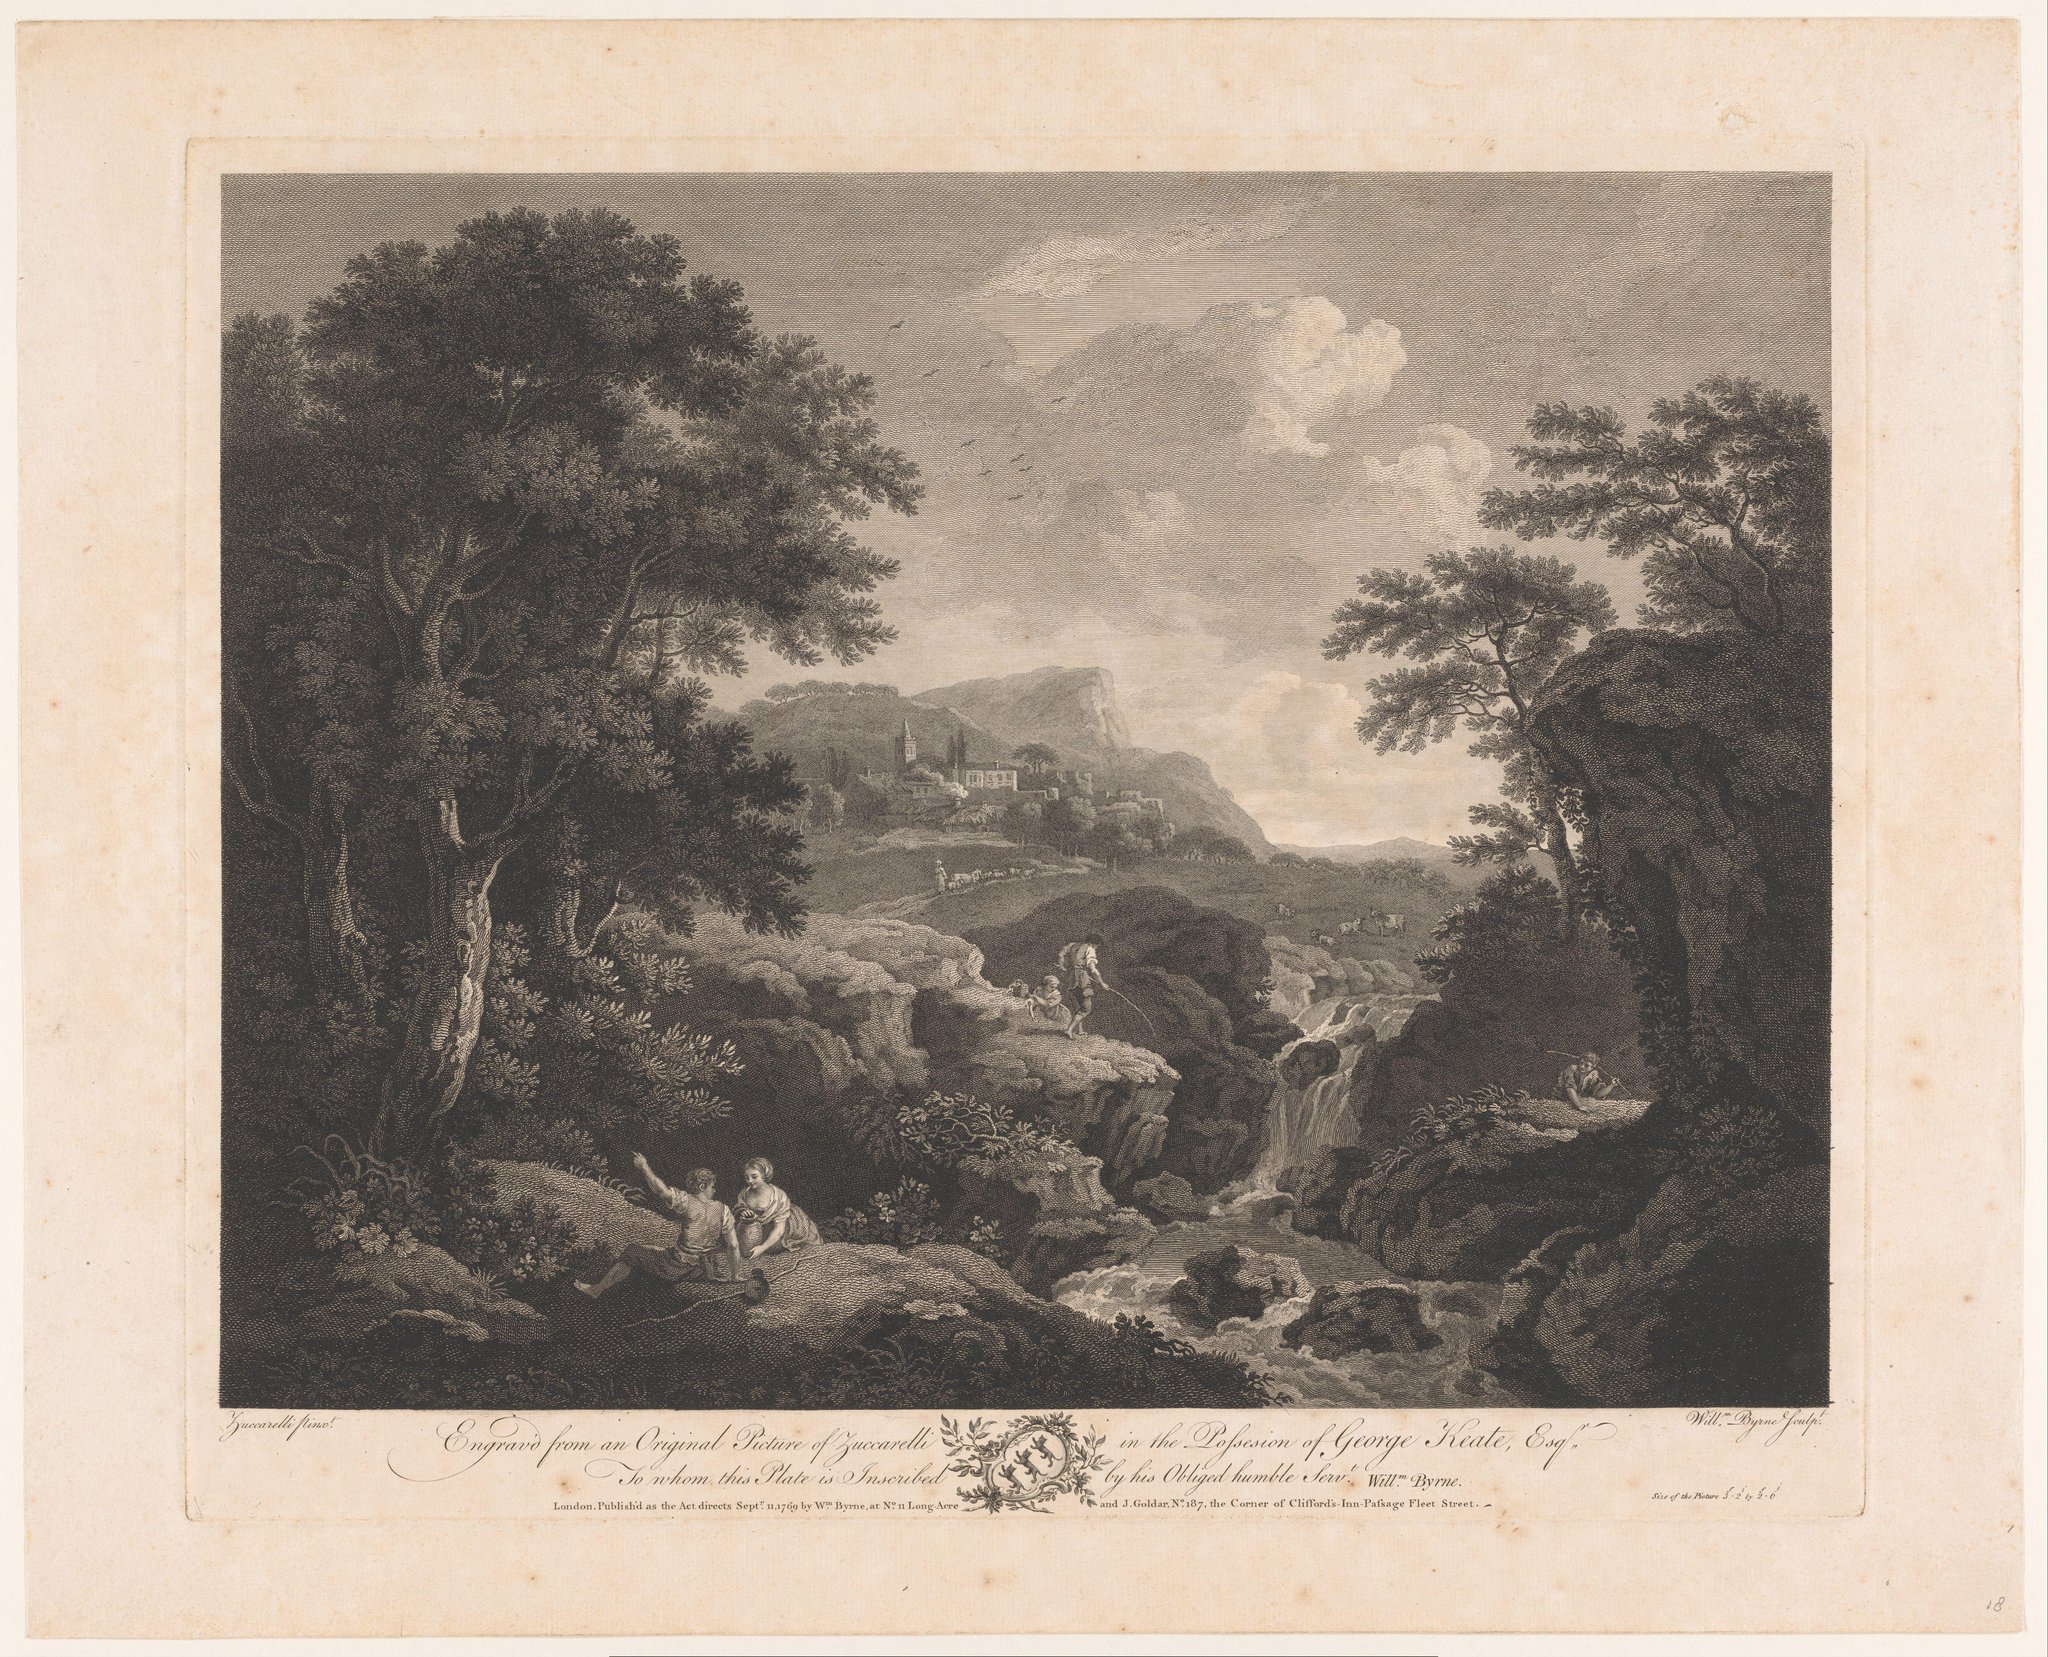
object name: print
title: Landschap met vissers bij een waterval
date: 1769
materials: paper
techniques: engraving, etching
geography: london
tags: waterfall, low hill country (+ landscape with figures, staffage)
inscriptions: collector's mark: Lugt 2228, collector's mark: Lugt 240